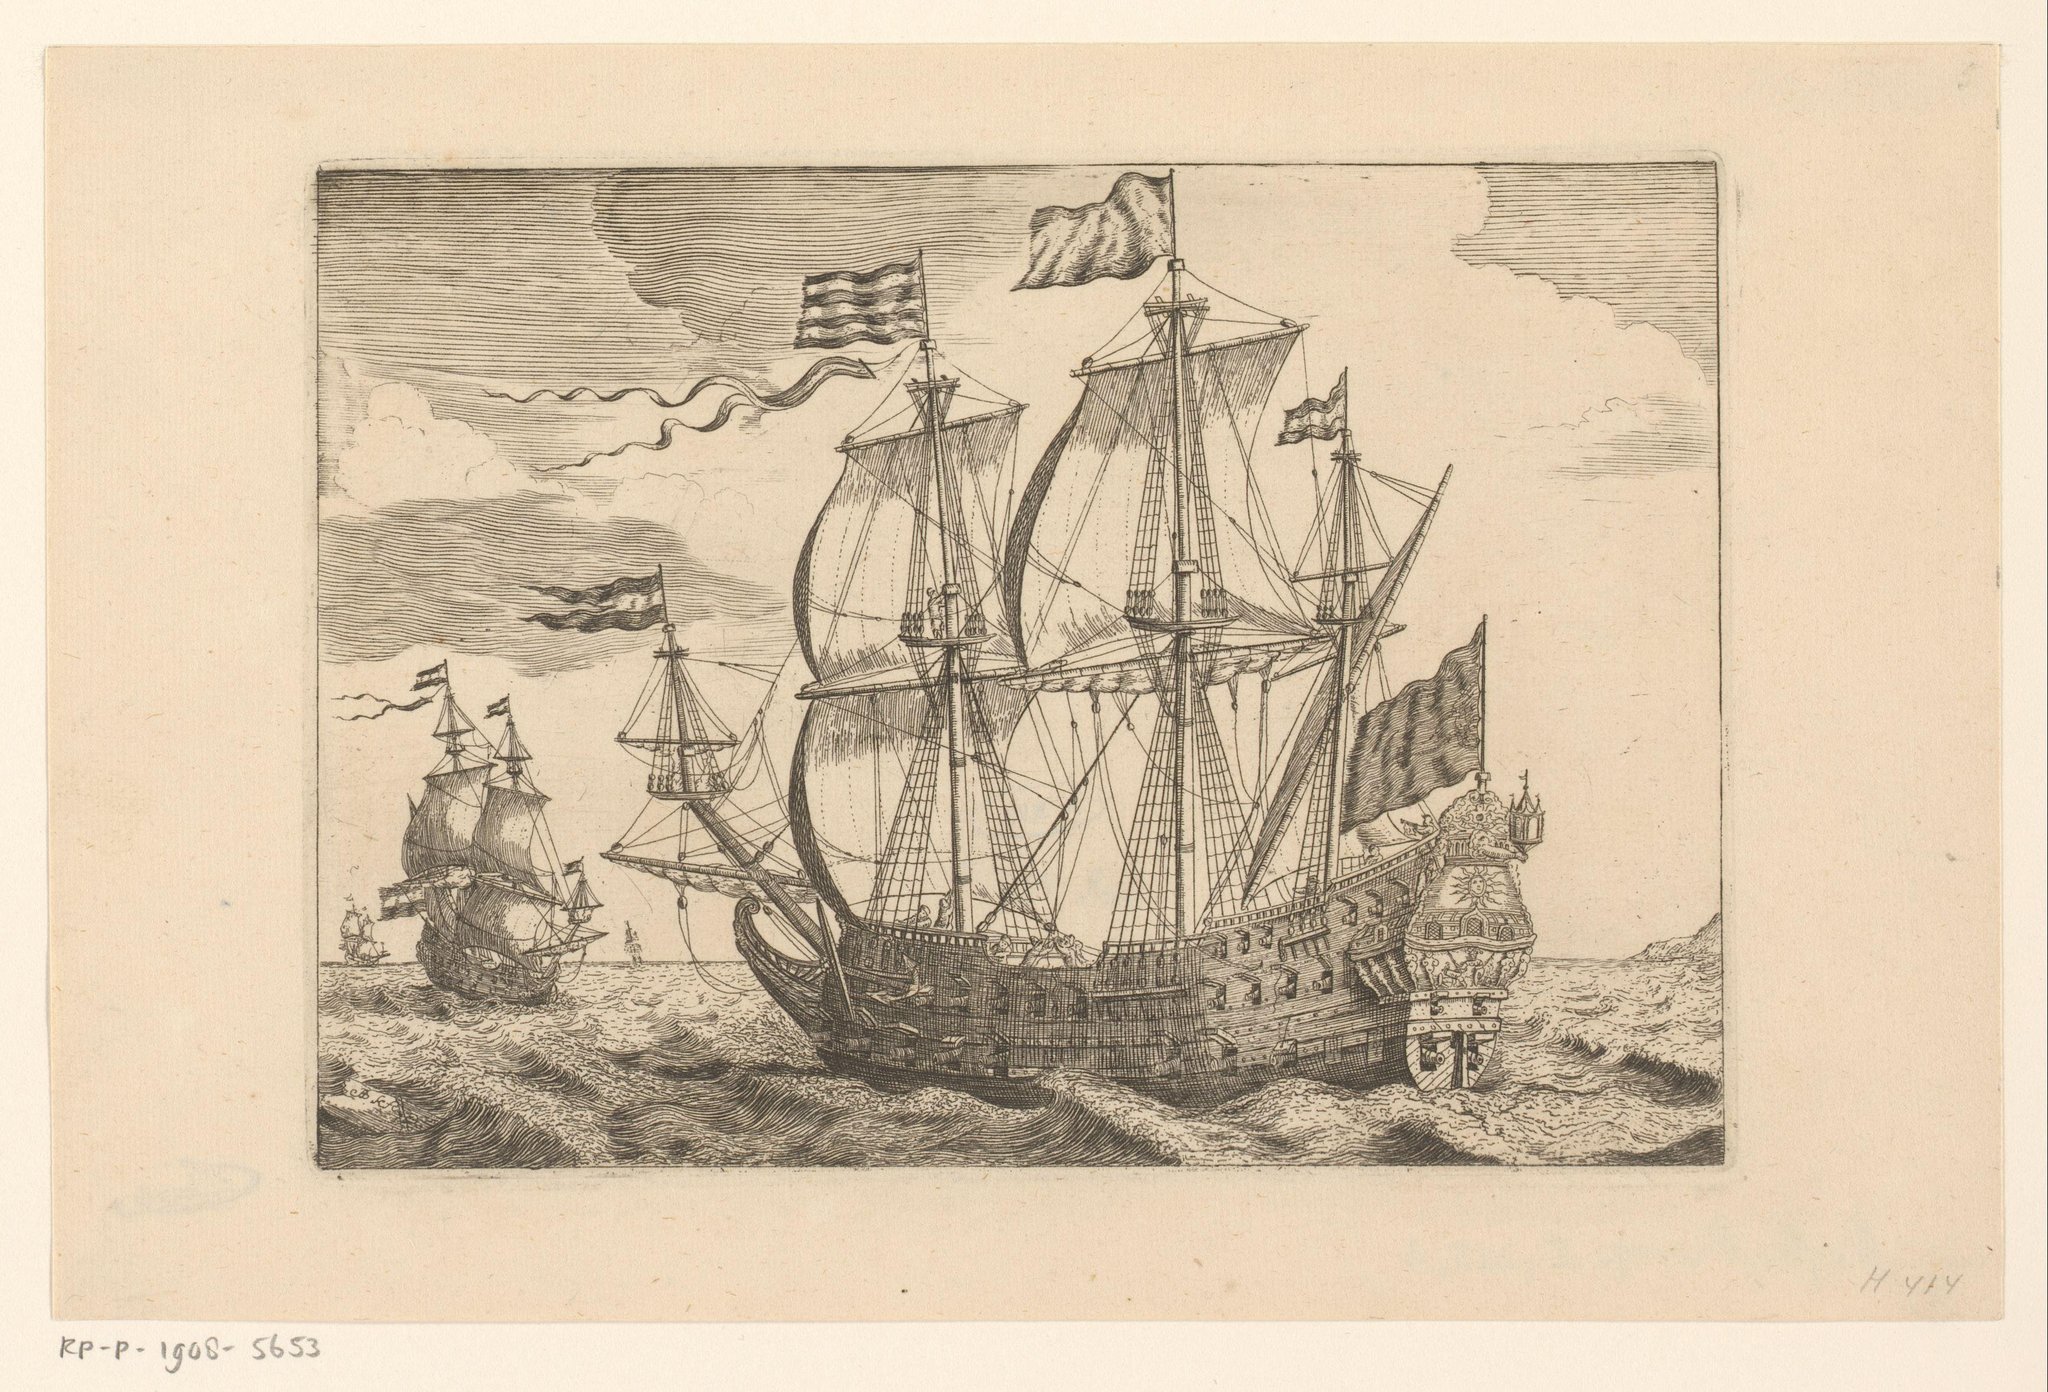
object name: print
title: Oorlogsschepen op zee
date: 1673-1709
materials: paper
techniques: etching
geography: northern netherlands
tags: sailing-ship, sailing-boat, sea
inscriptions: collector's mark: Lugt 2162, collector's mark: Lugt 2228